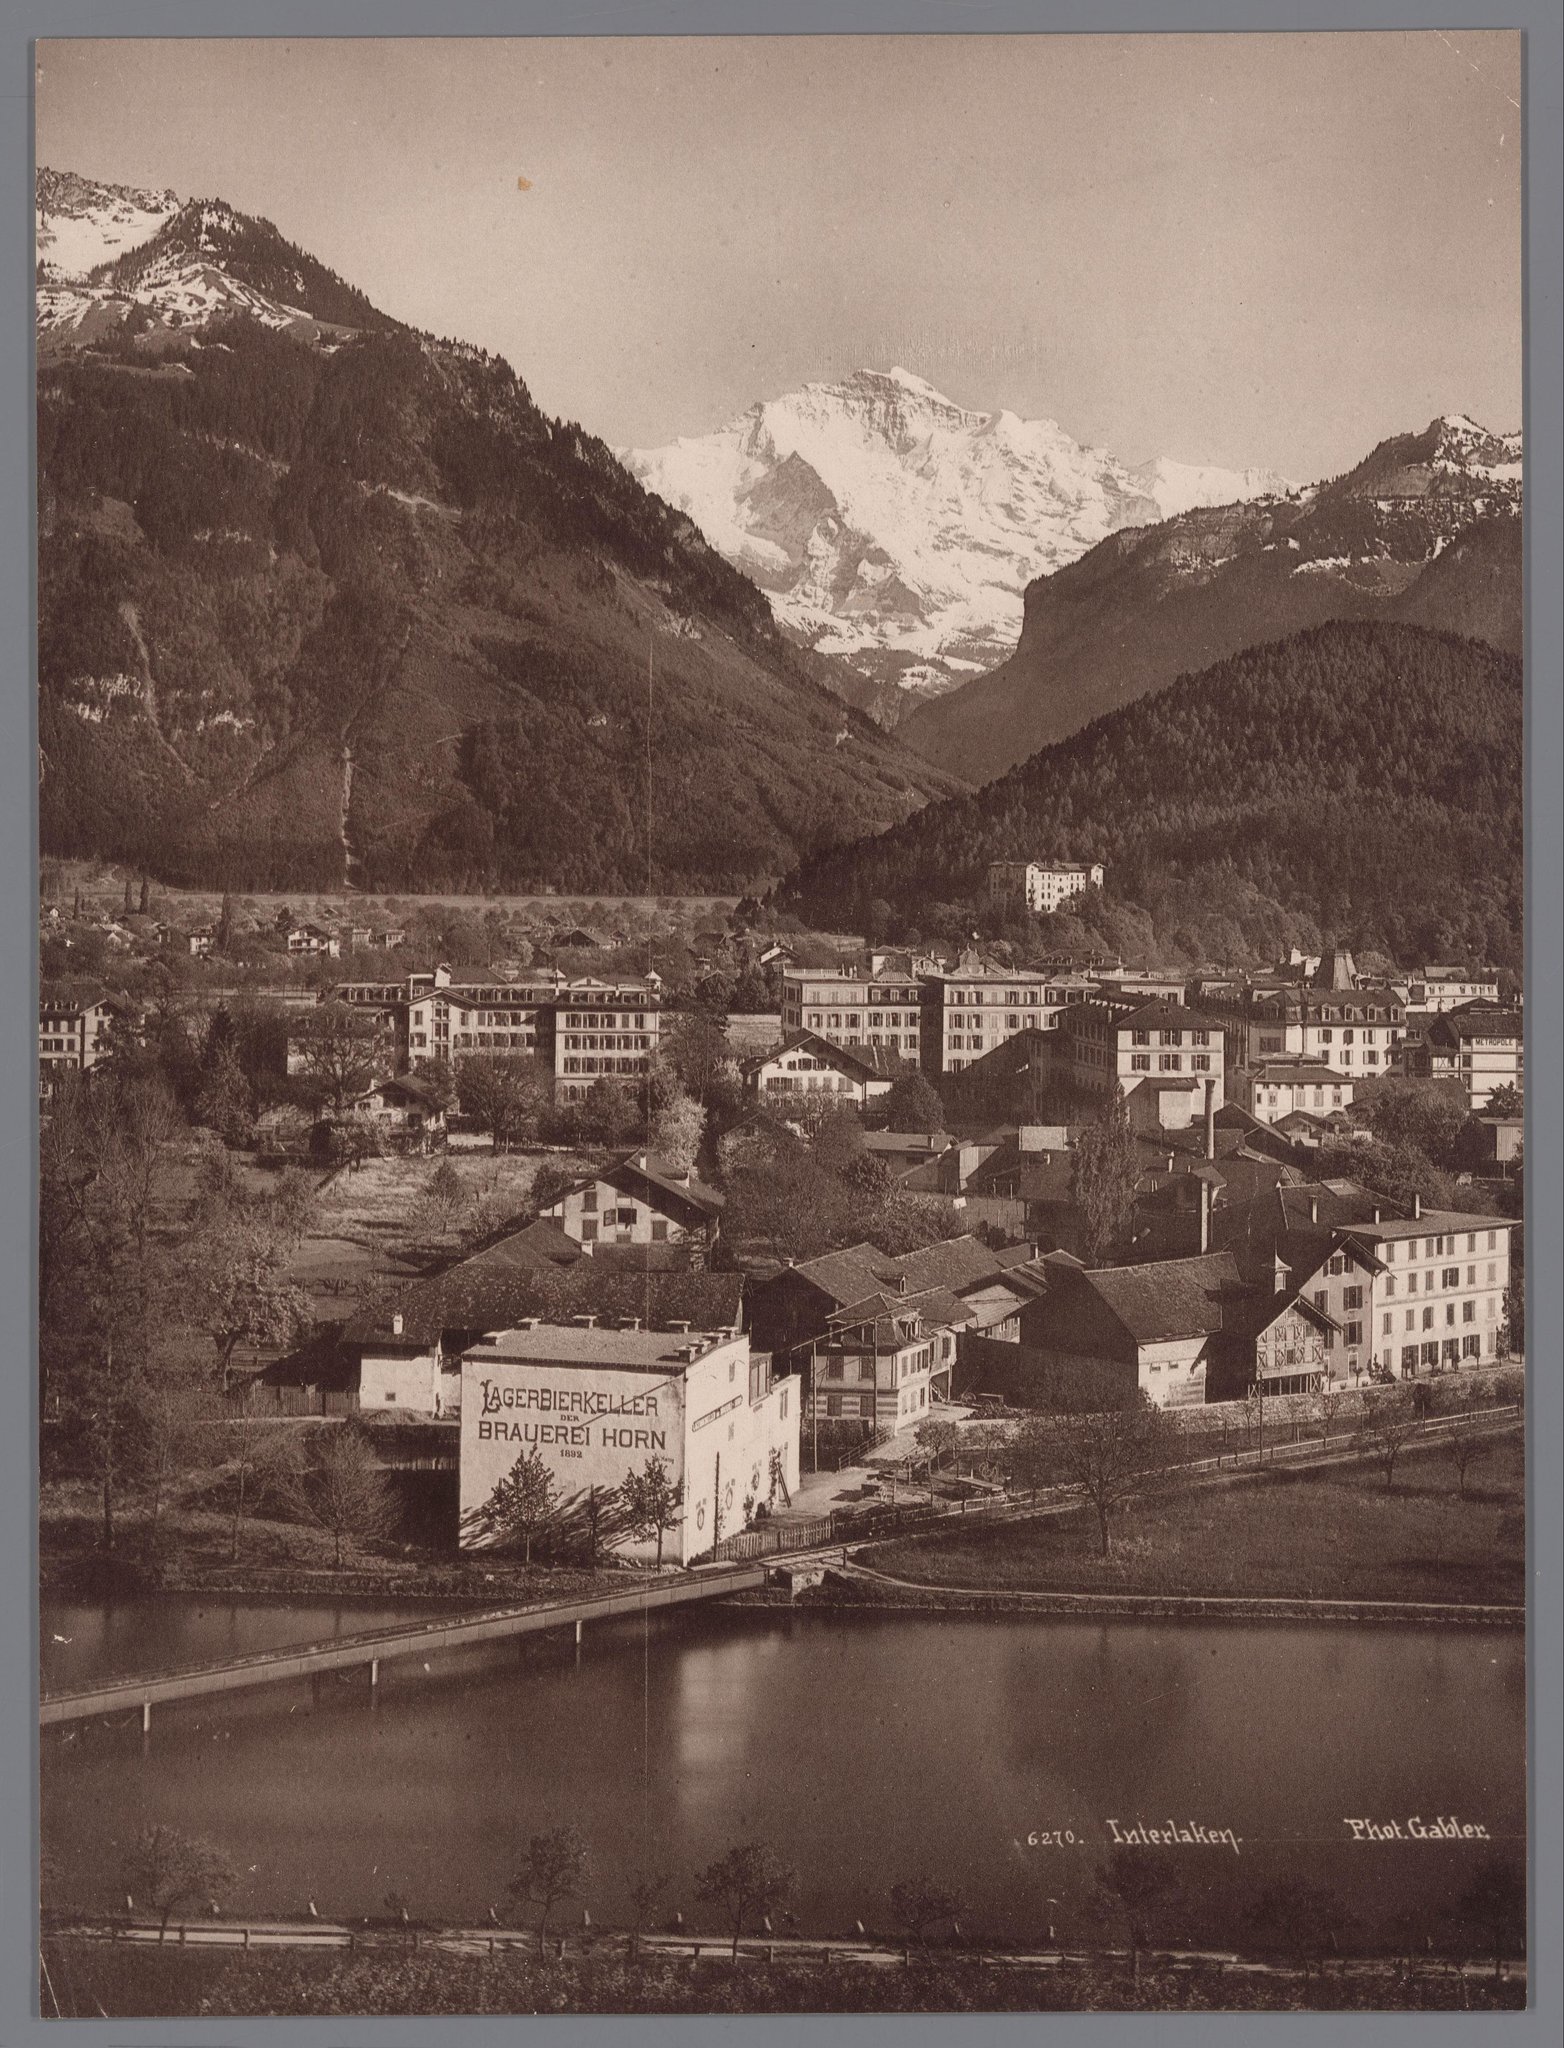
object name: photomechanical print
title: Gezicht op Interlaken, op de voorgrond de brouwerij van Emil Horn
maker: arthur gabler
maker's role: publisher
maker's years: 1867-1927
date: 1892-1930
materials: cardboard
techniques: photograph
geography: interlaken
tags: city-view in general; 'veduta'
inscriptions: number: ‘6270.’